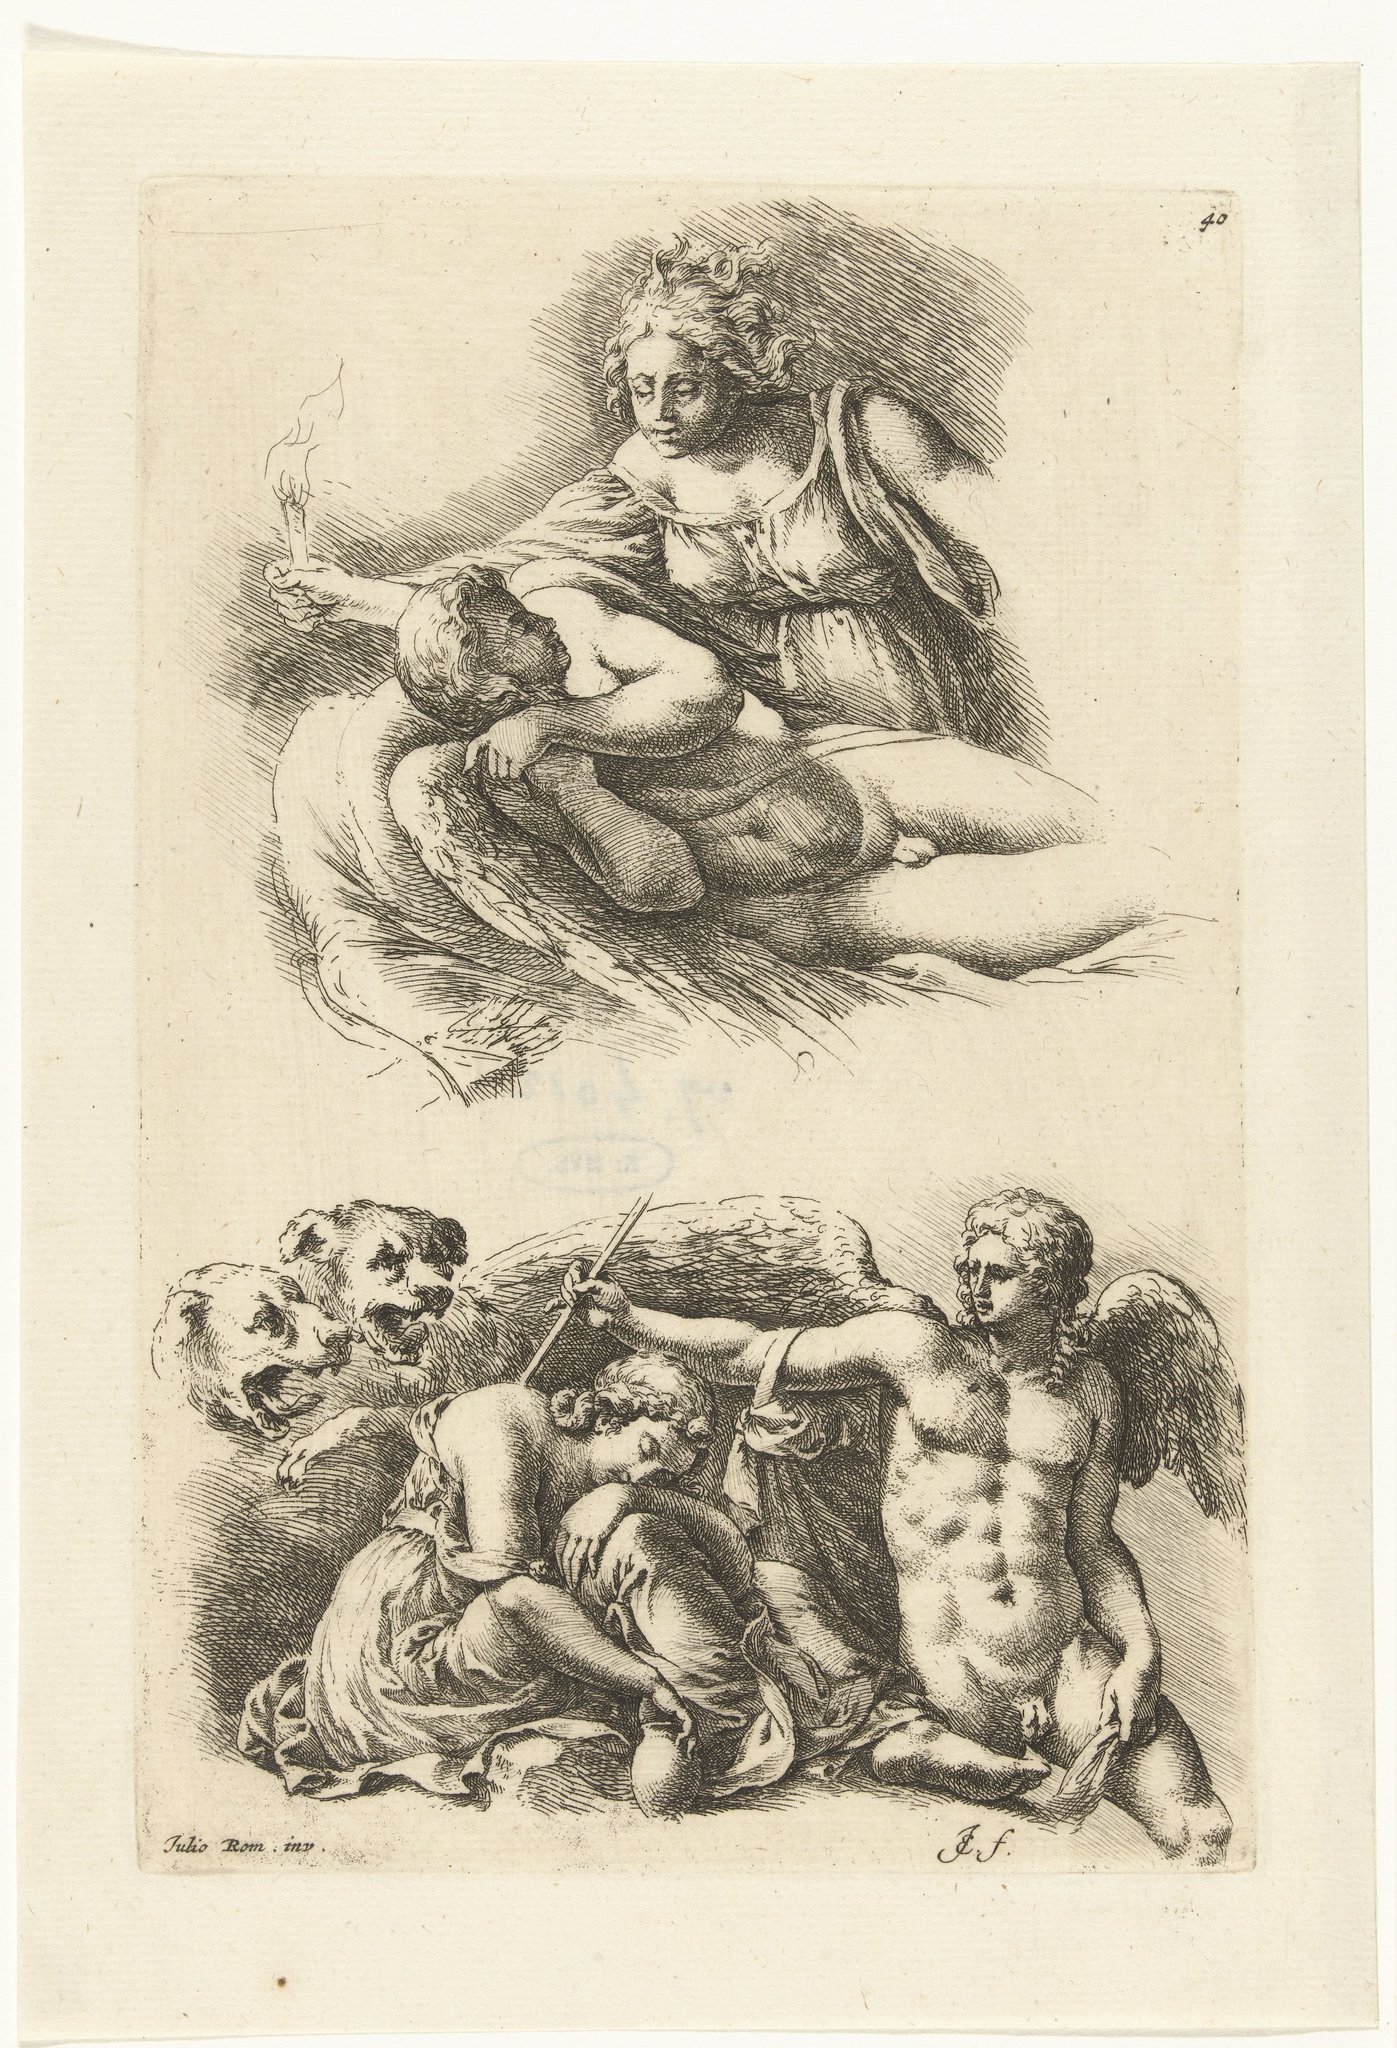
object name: print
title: Twee scènes uit het verhaal van Amor en Psyche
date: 1668-1671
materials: paper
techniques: etching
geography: northern netherlands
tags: other scenes from the story of cupid and psyche, psyche, holding a lamp, gazes at the sleeping cupid, who awakens when a drop of hot oil falls on him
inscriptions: collector's mark: Lugt 2228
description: afkomstig uit: Paradigmata graphices variorum artificum : voor-beelden der teken-konst van verscheyde meesters, Hagae-Comitis, (2e of latere editie)